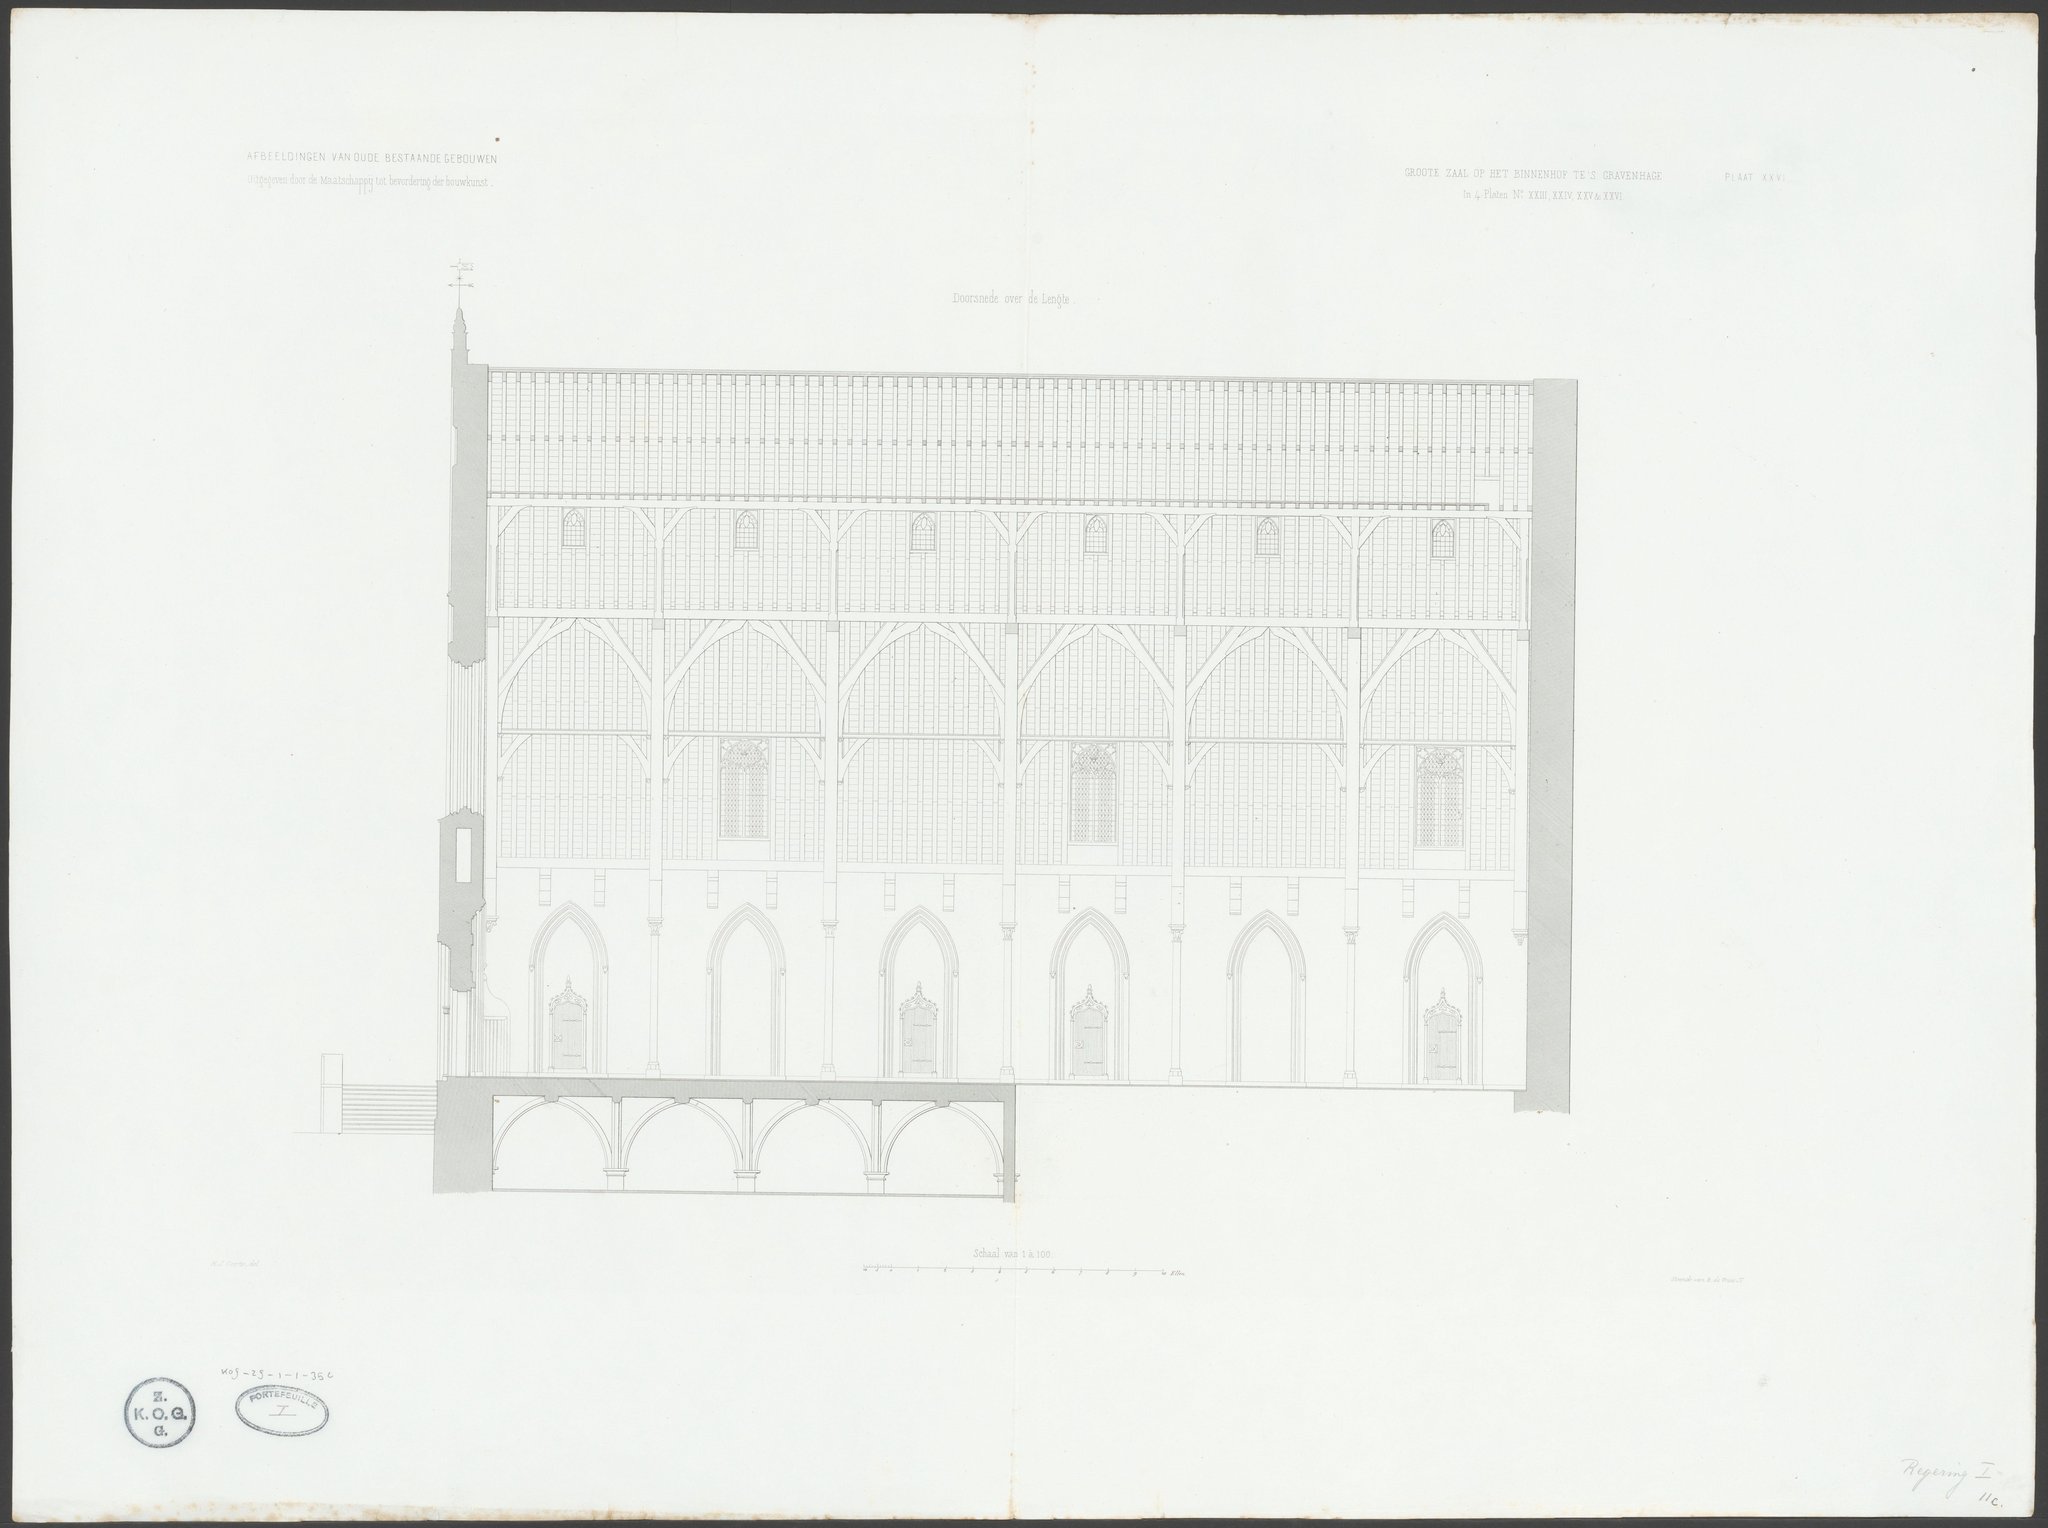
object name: print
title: Doorsnede over de Lengte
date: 1859-1874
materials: paper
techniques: lithograph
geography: netherlands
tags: representation of real building (either existing or having existed)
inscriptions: collector's mark, collector's mark: Lugt 1641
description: Doorsnede van de Ridderzaal, Binnenhof, Den Haag. Onderaan een schaalstok. Architectuurvoorstelling. Plaat XXVI. Onderwerpsrubrieken binnen de Atlas Zeden en Gewoonten: Regeering, Staten-Generaal.